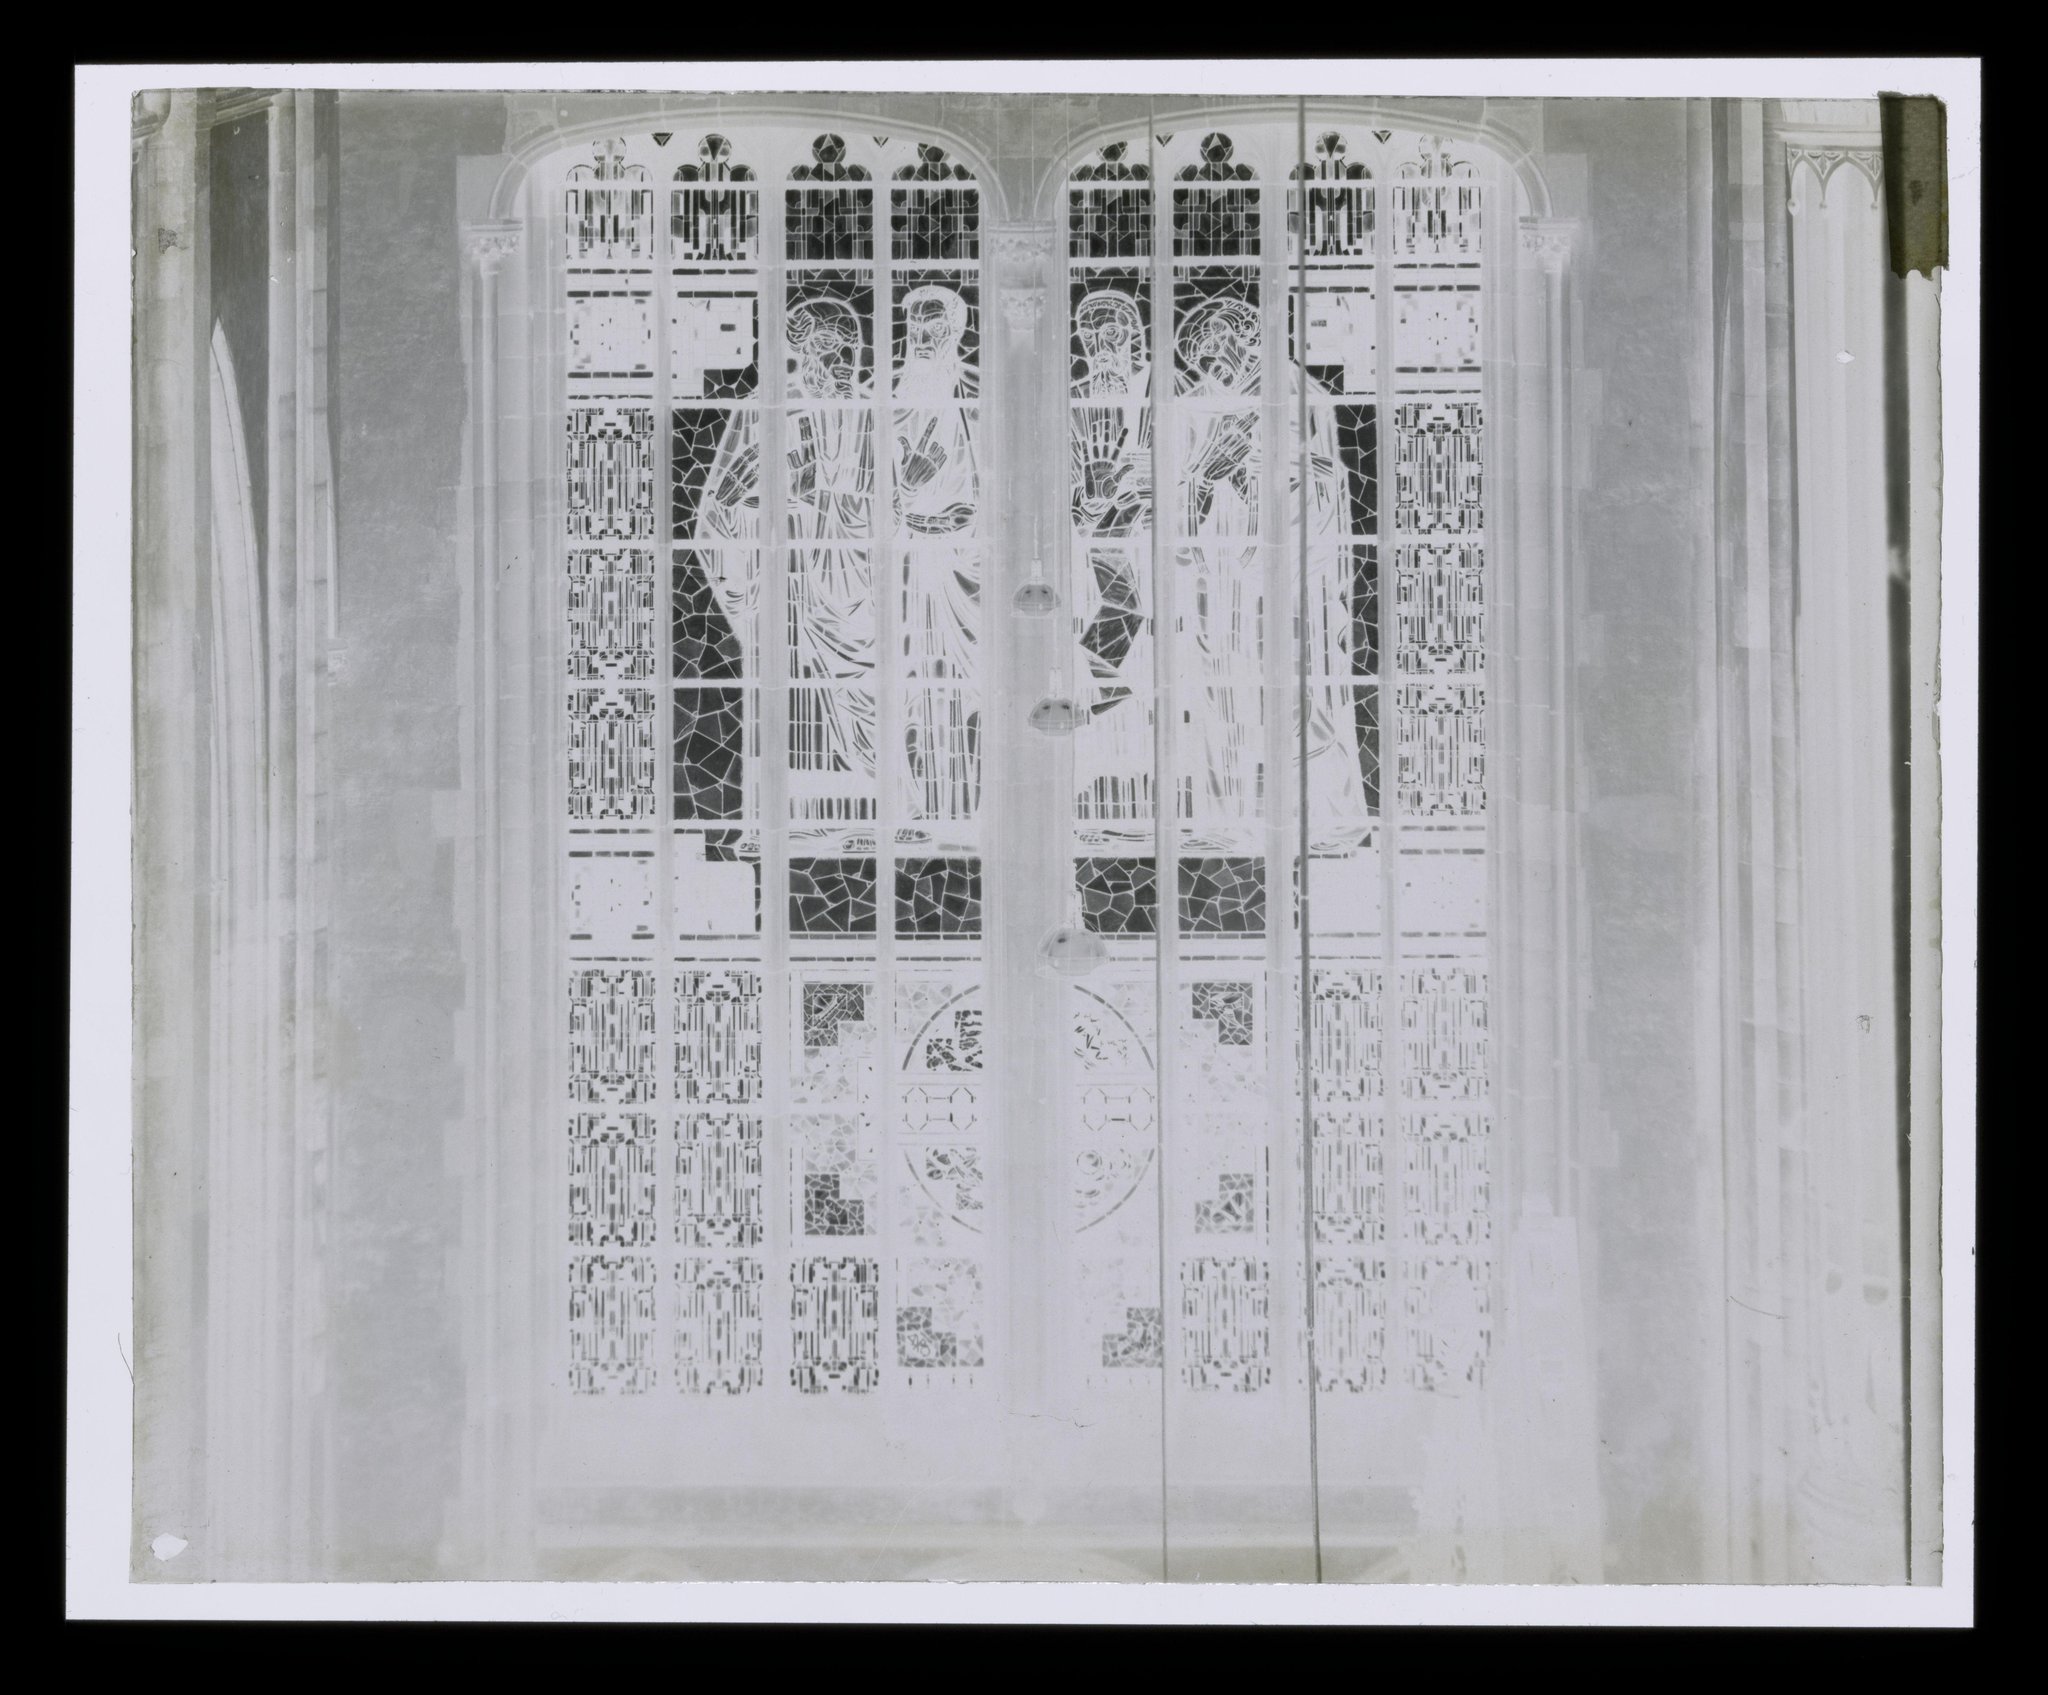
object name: glasnegatief, glasplaatnegatief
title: Fotoreproductie van het onderste deel van het Evangelistenraam gemaakt door Richard Nicolaüs Roland Holst in de Dom van Utrecht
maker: Anonymous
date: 1926-1938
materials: glass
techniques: gelatin glass negative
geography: utrecht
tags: church-window, e.g. rose-window